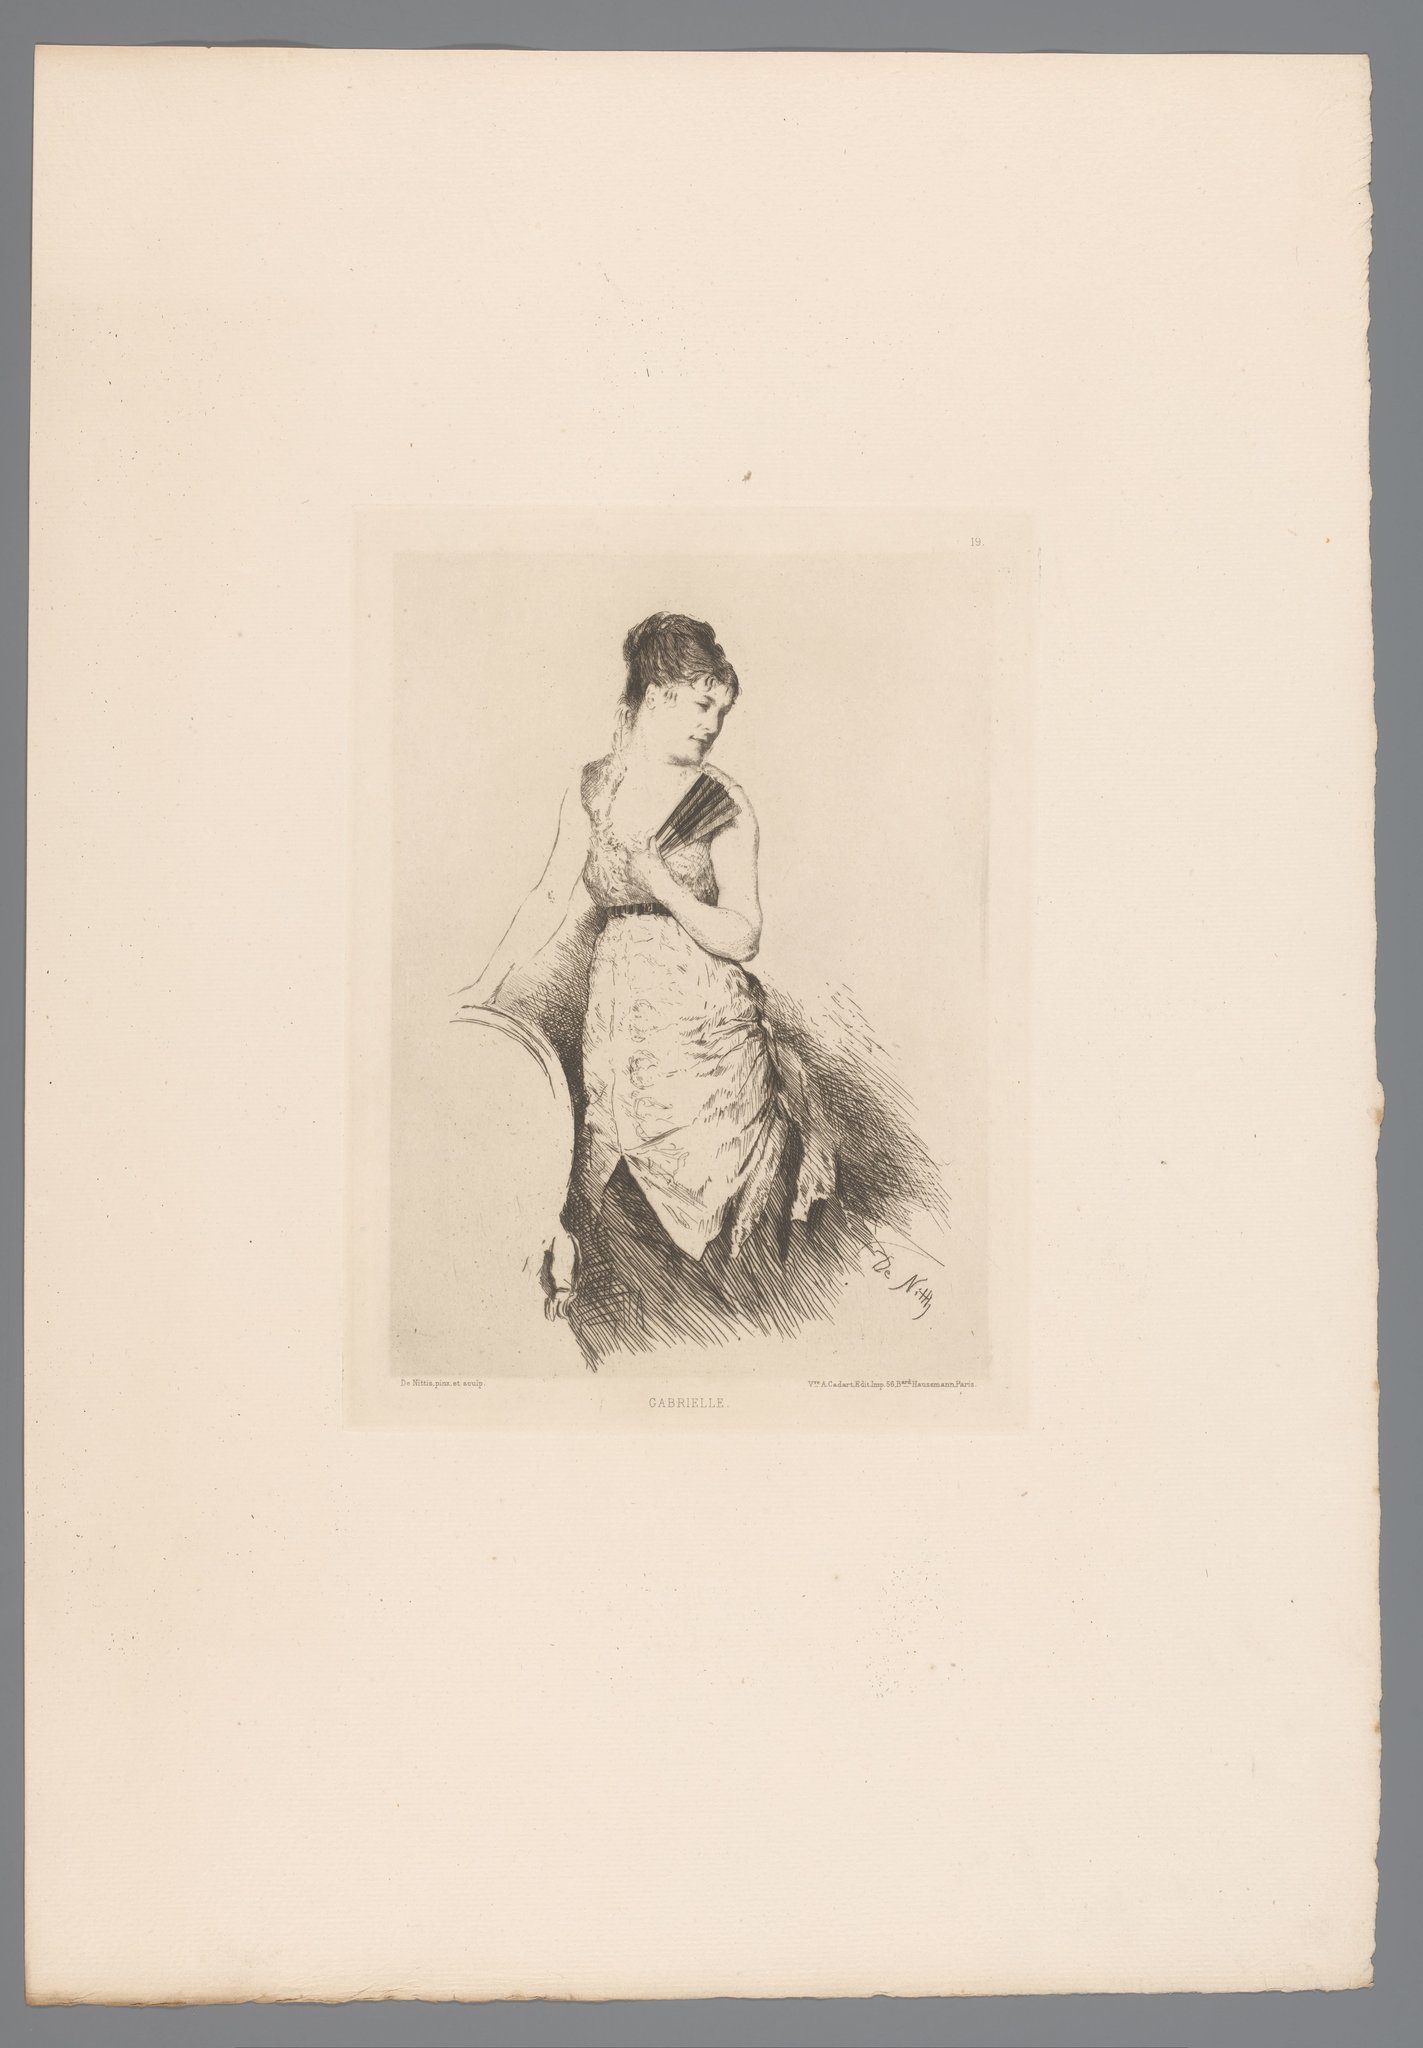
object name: print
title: Portret van een vrouw genaamd Gabrielle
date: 1876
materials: paper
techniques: drypoint, etching, intaglio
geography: paris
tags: historical persons - bb - woman, standing figure - aa - female human figure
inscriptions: watermark, collector's mark: Lugt 2760, collector's mark: Lugt 2228, collector's mark: ‘AFE v S’